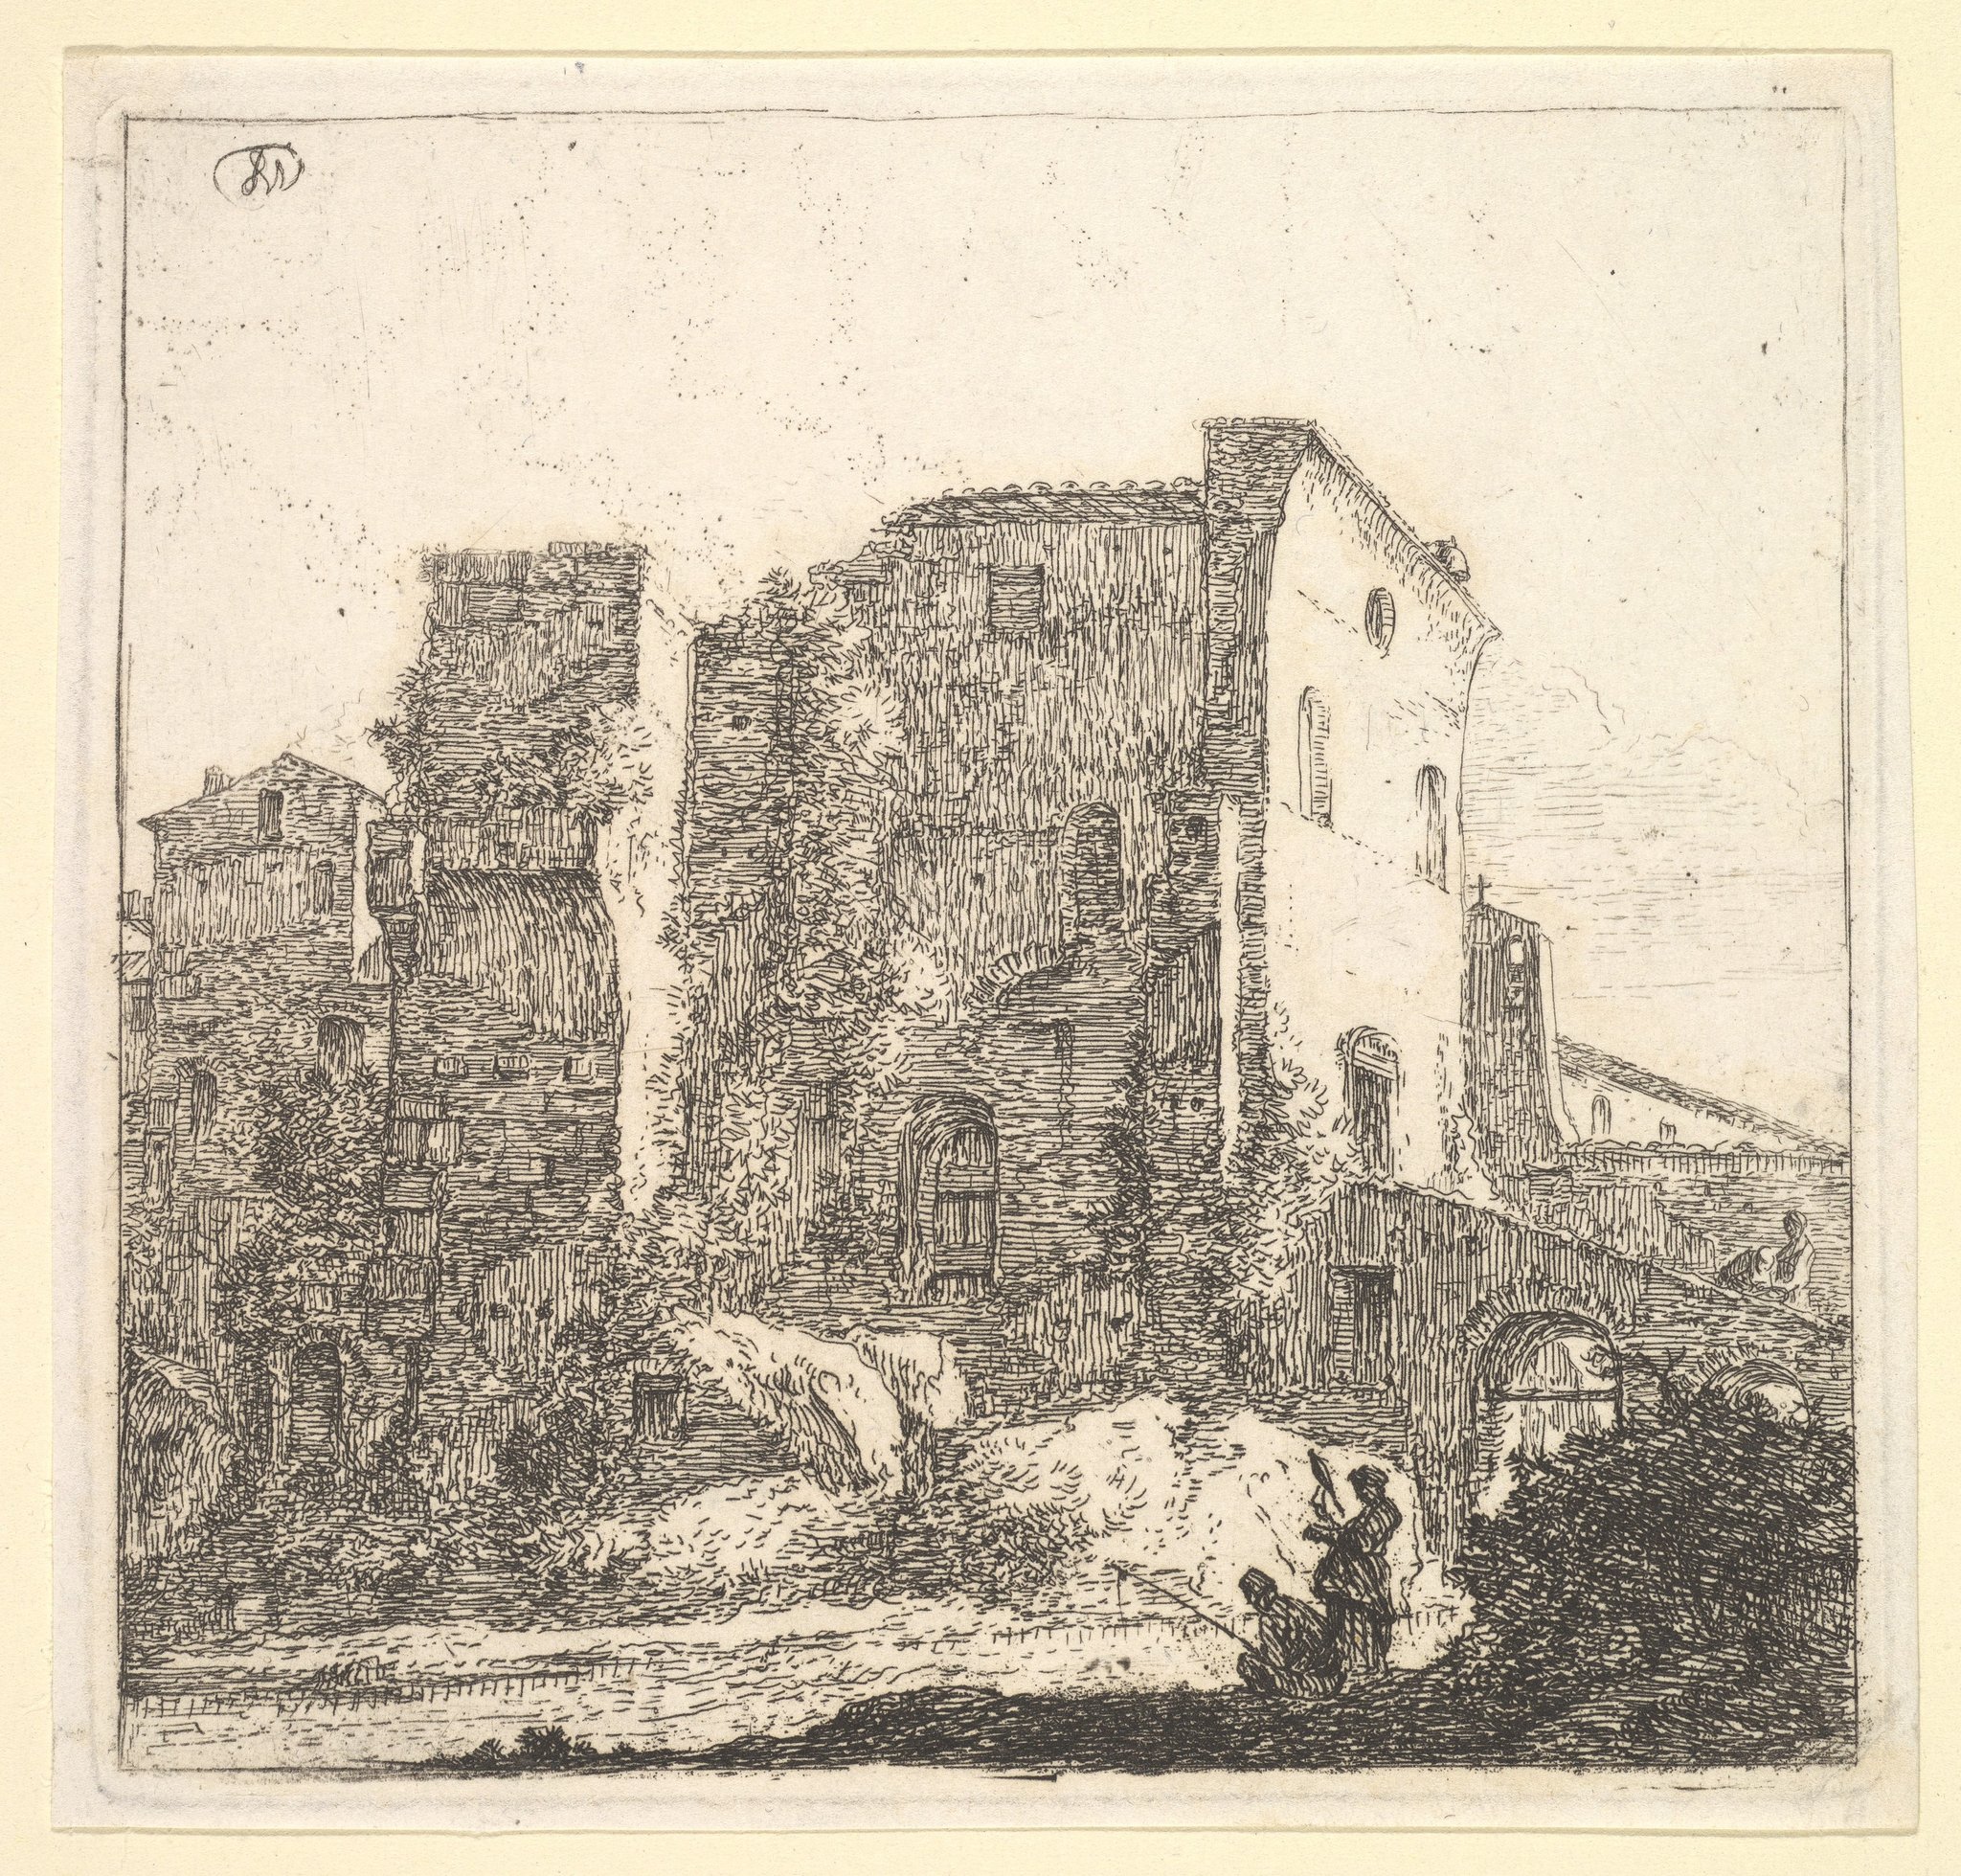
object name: print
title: A Woman Spinning and a Fisherman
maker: thomas wijck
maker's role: artist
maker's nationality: dutch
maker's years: 1616-1677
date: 1601-1700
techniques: etching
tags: buildings,men,women,fishing